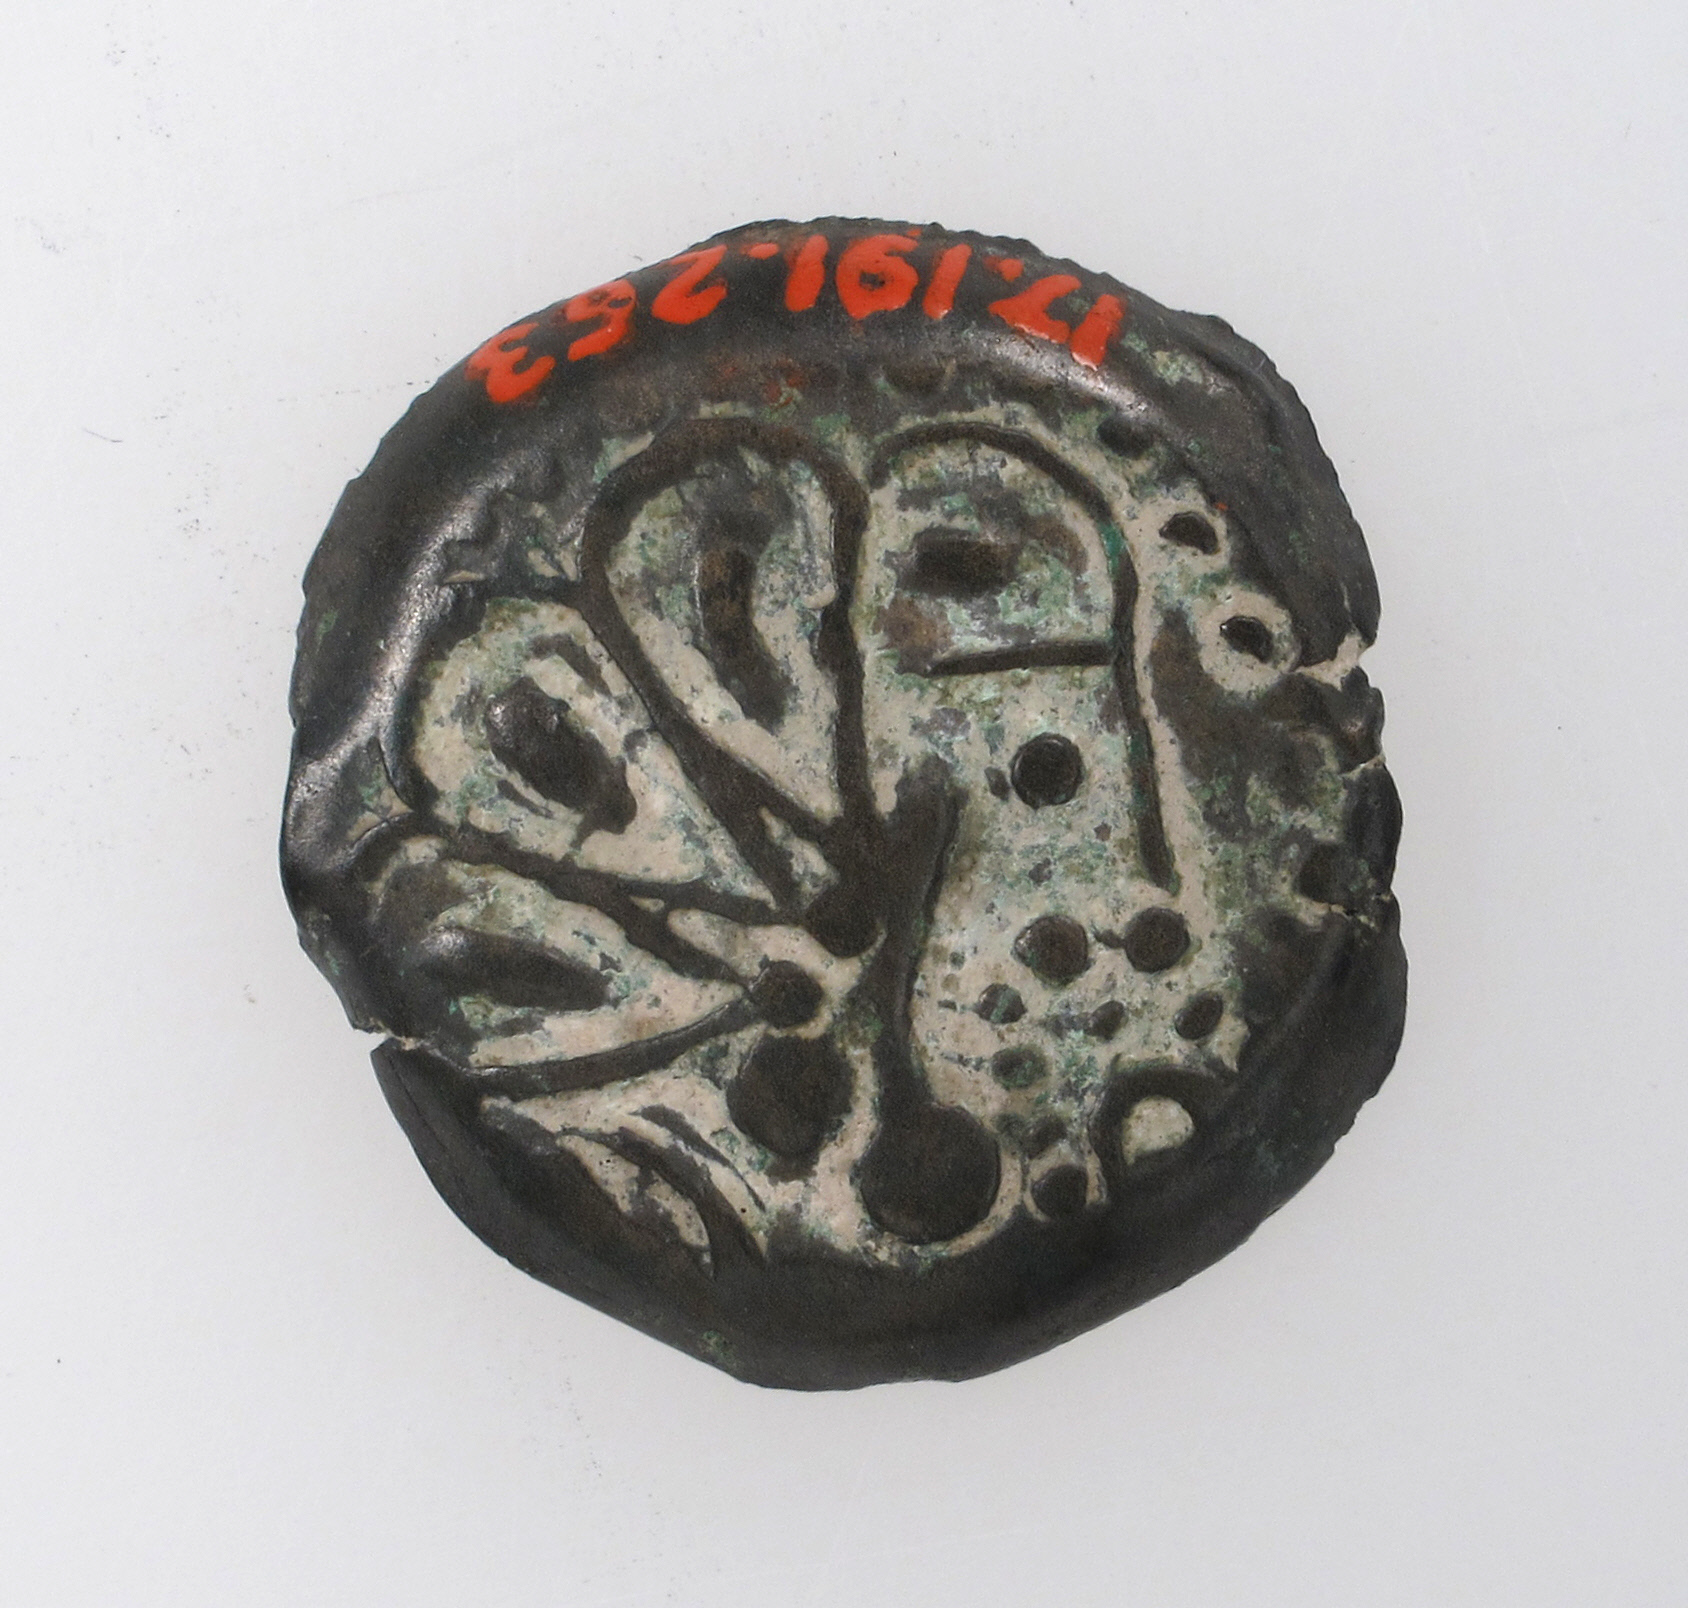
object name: coin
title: Coin of The Senones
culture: roman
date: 200-500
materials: copper alloy